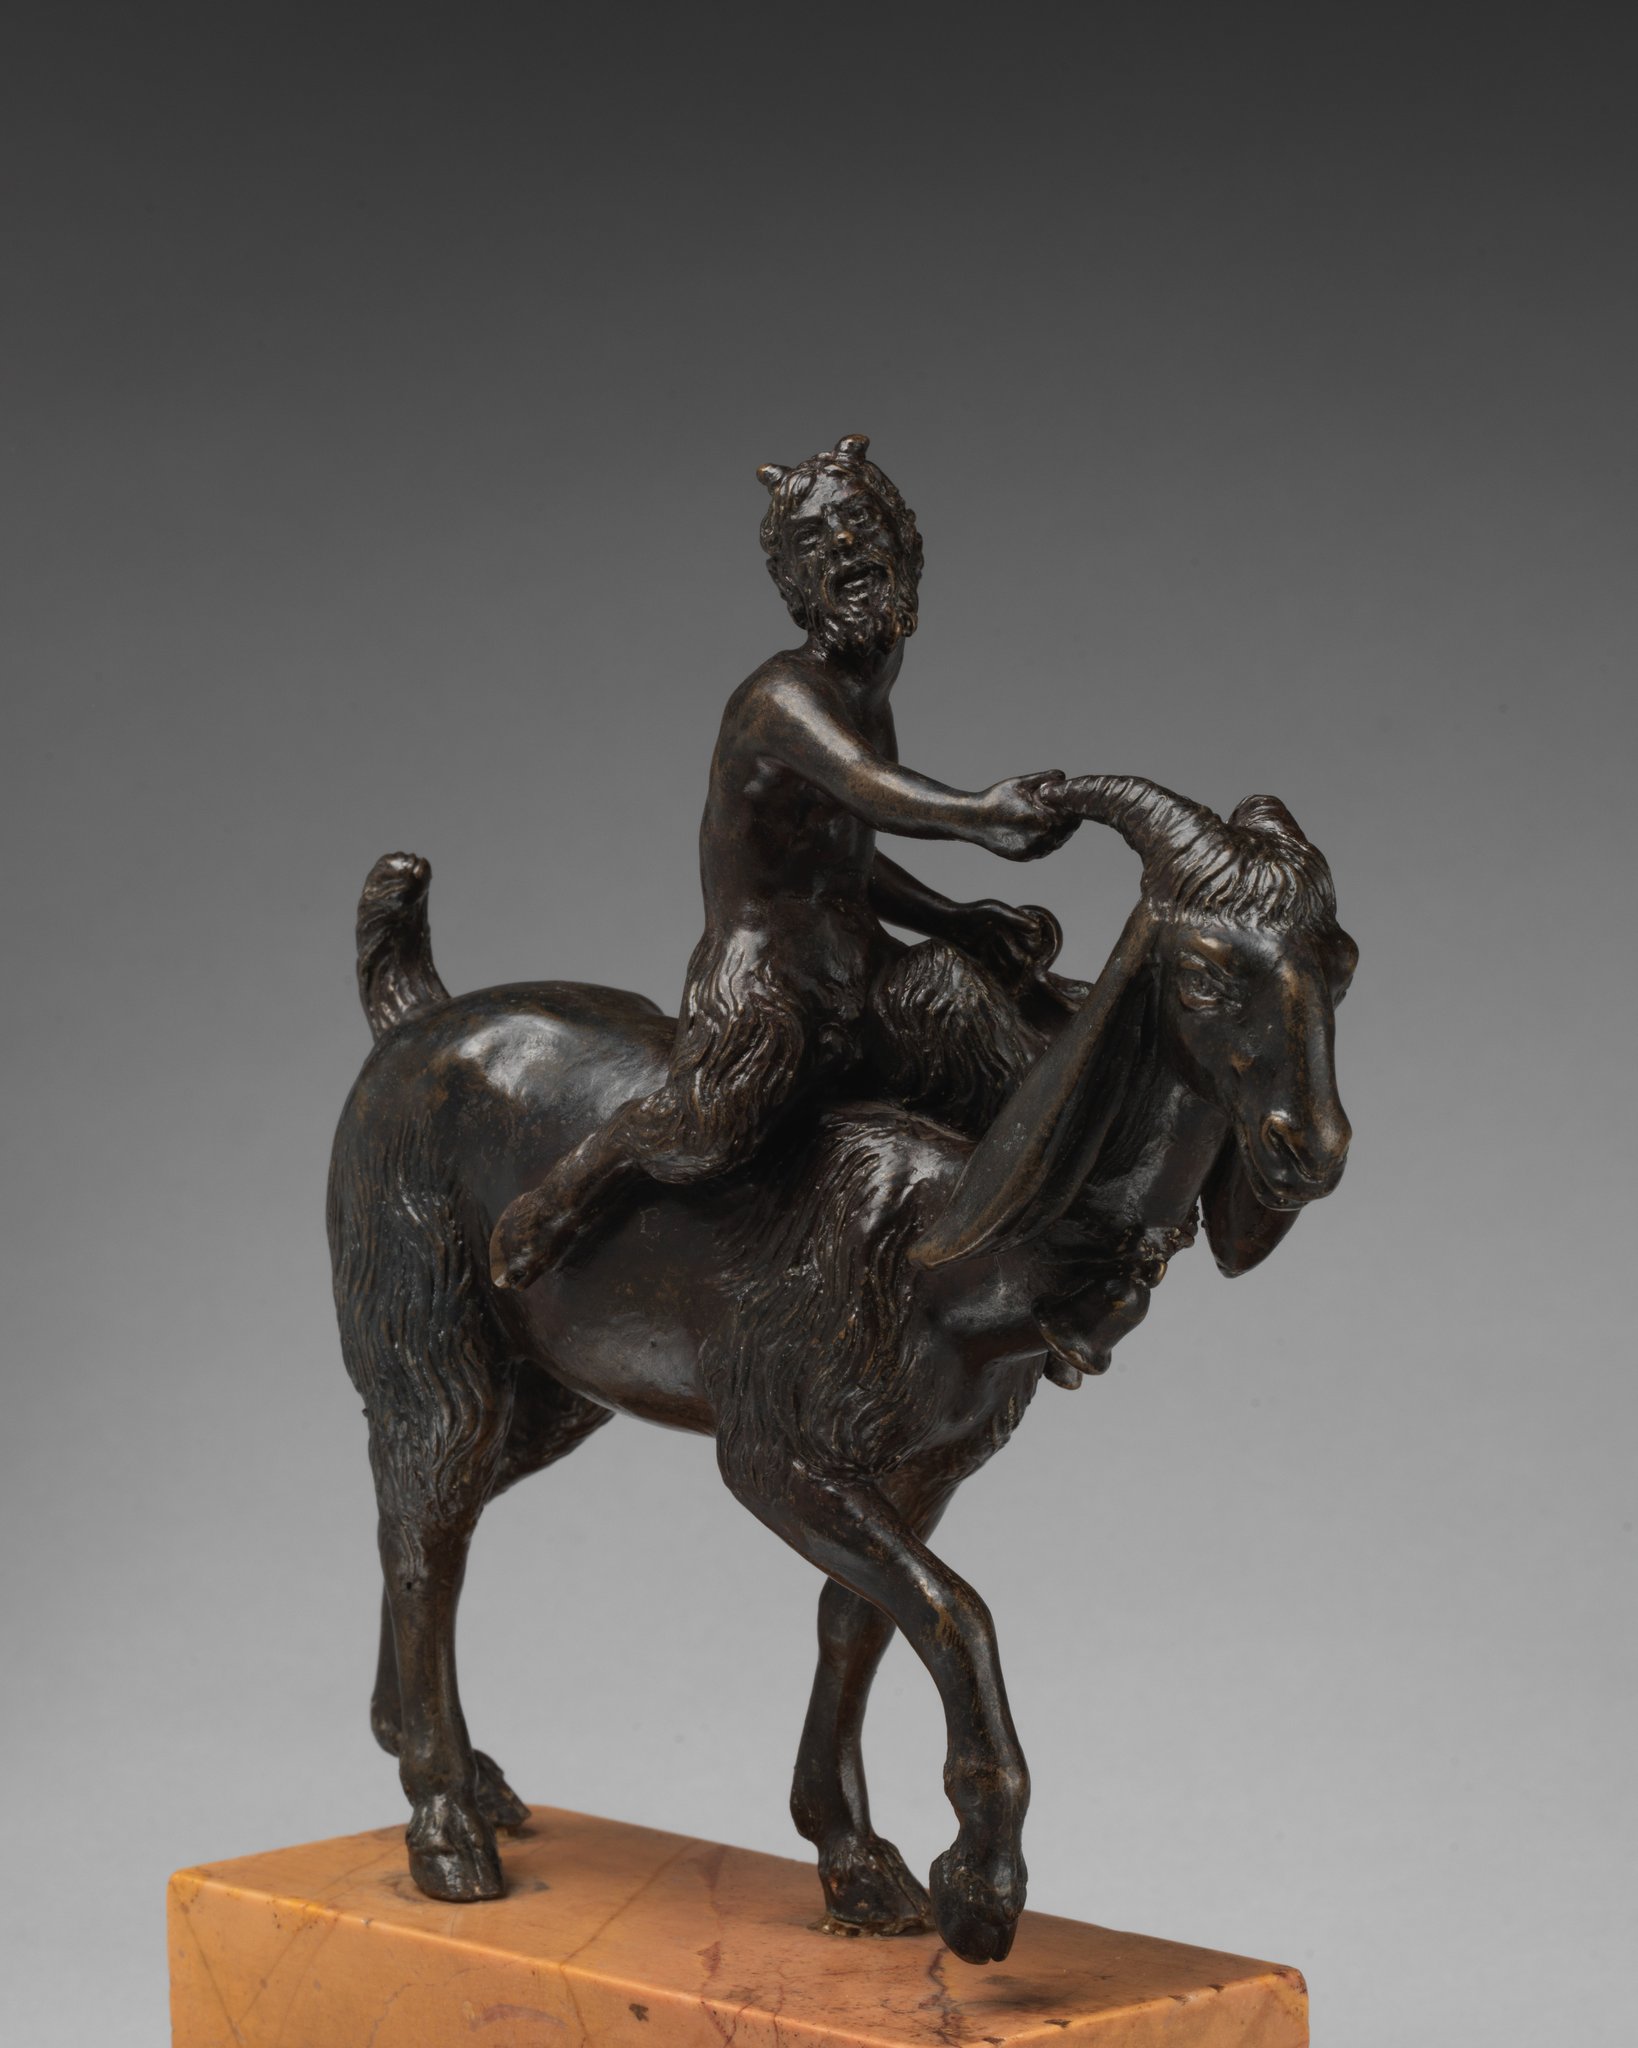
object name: statuette group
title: Satyr Riding a Goat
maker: andrea briosco, called riccio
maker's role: artist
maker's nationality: italian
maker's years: 1470-1532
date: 1801-2000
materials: bronze, marble, patina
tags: satyrs,goats